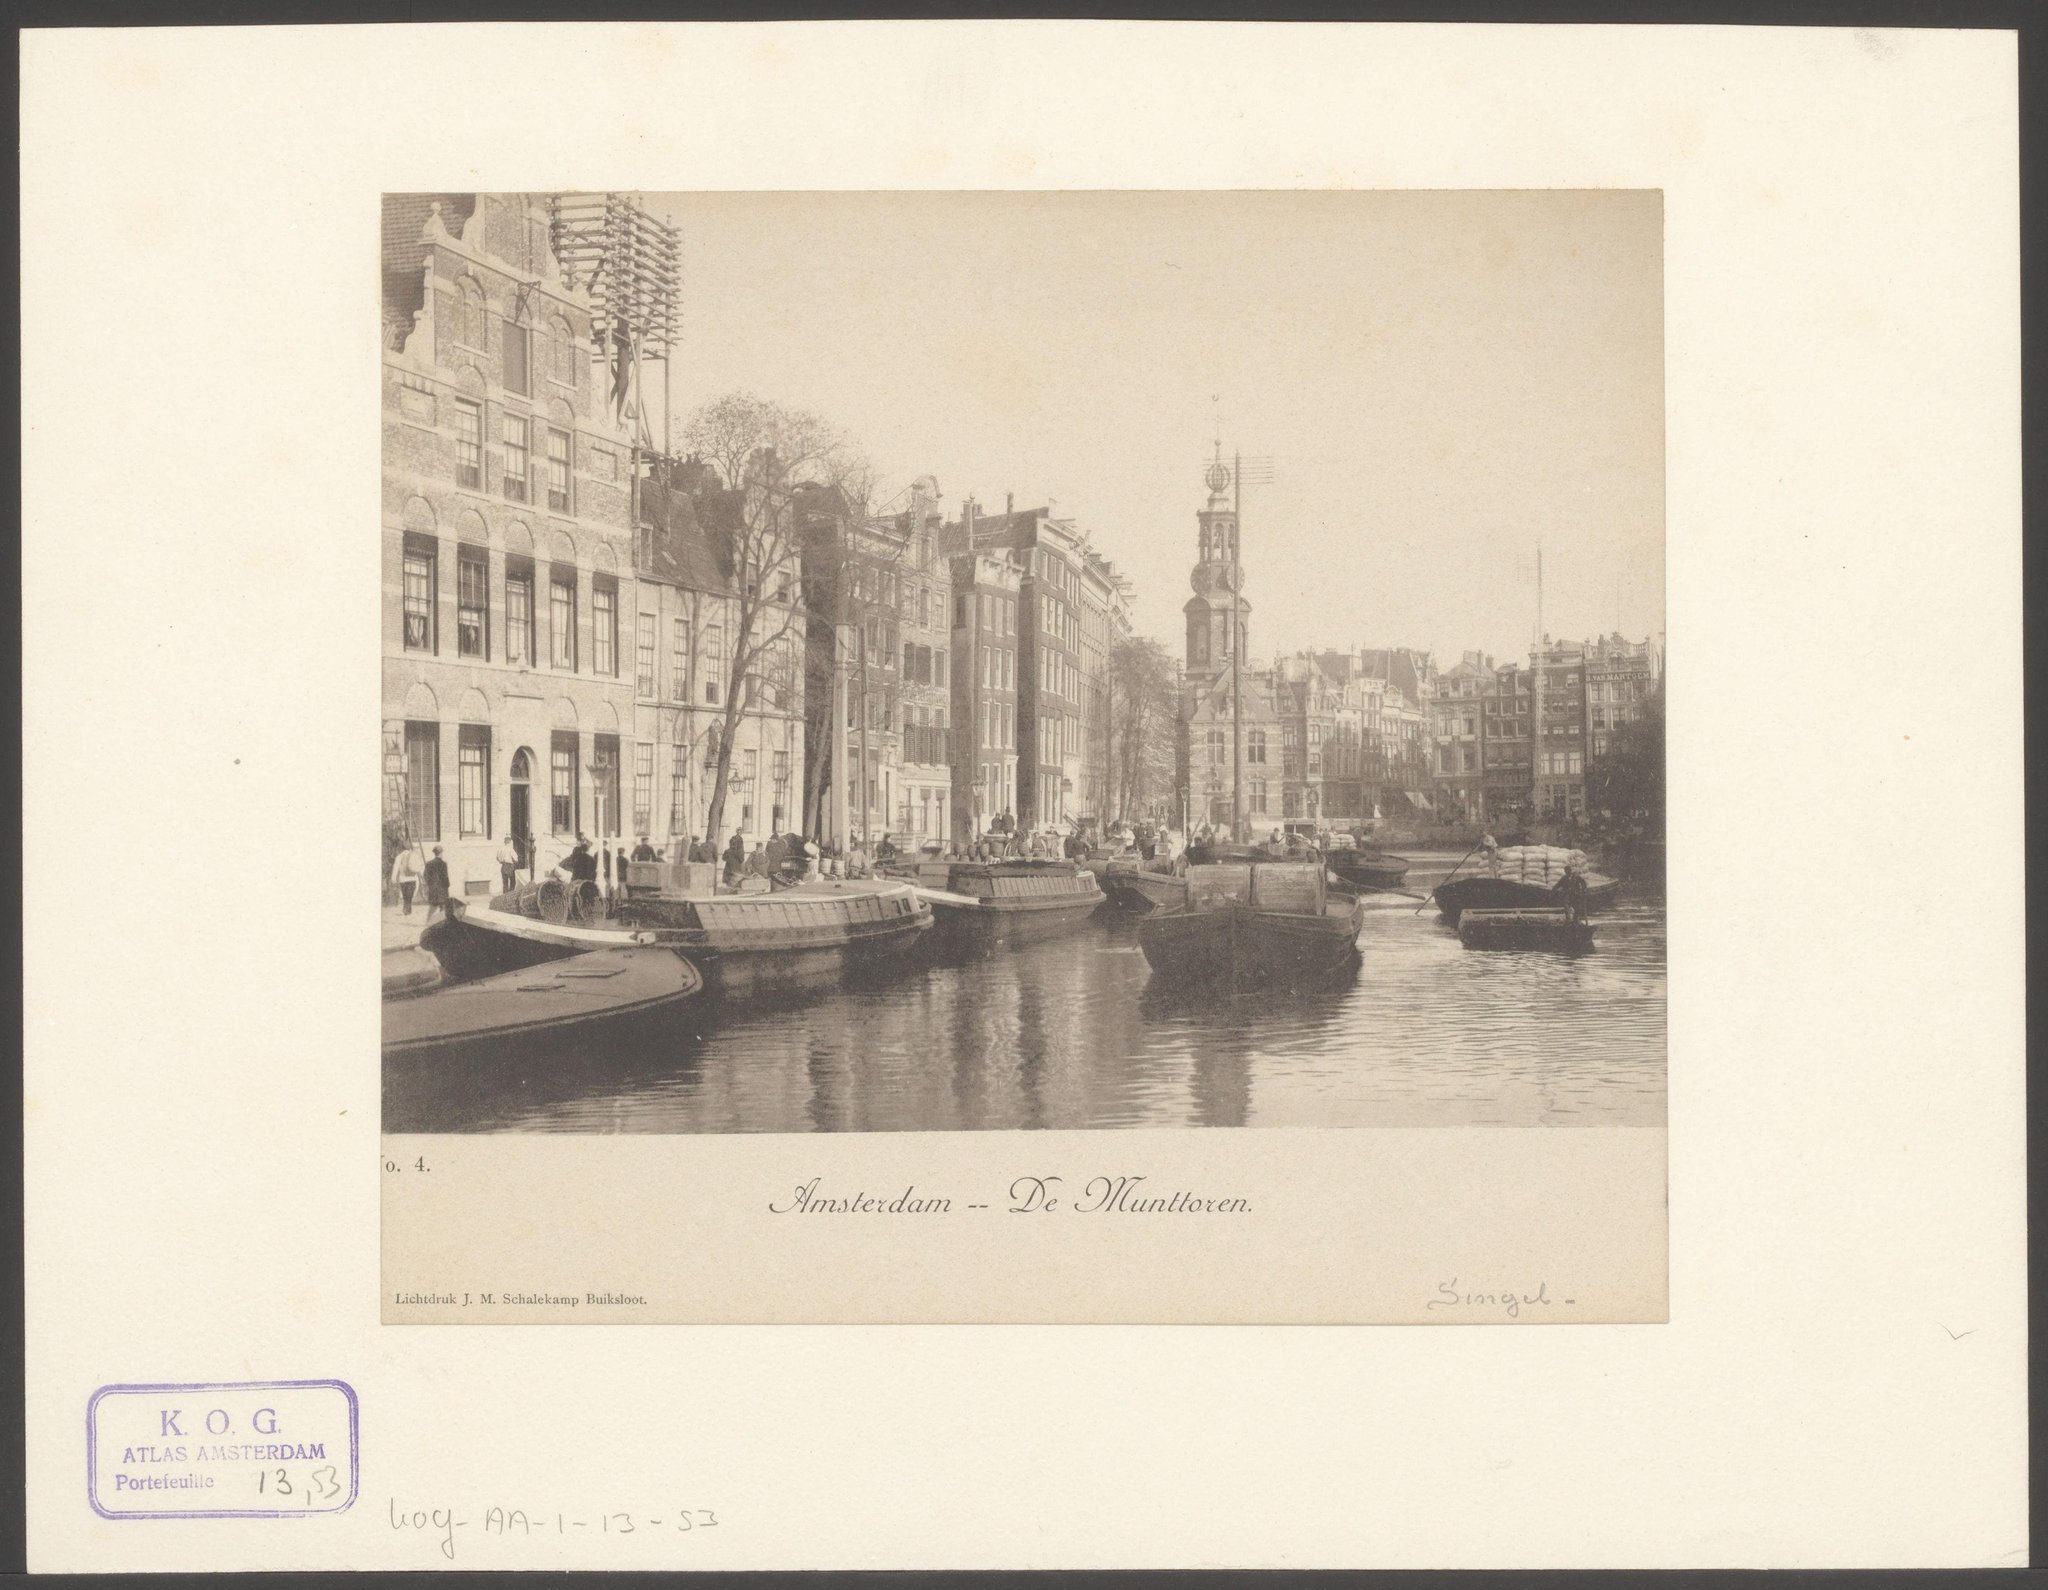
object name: ansichtkaart, prentbriefkaart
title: Gezicht op de Munttoren van het Singel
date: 1893-1905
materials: cardboard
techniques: photograph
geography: buiksloot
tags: tower, clock tower ~ monumental adornment, city-view in general; 'veduta', canal, street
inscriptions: collector's mark: ‘13,53’ Lugt 1641b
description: Onderwerpsrubriek binnen de Atlas Amsterdam: Oude Schans, Schoutensteeg, Singel (Korte), Singel.